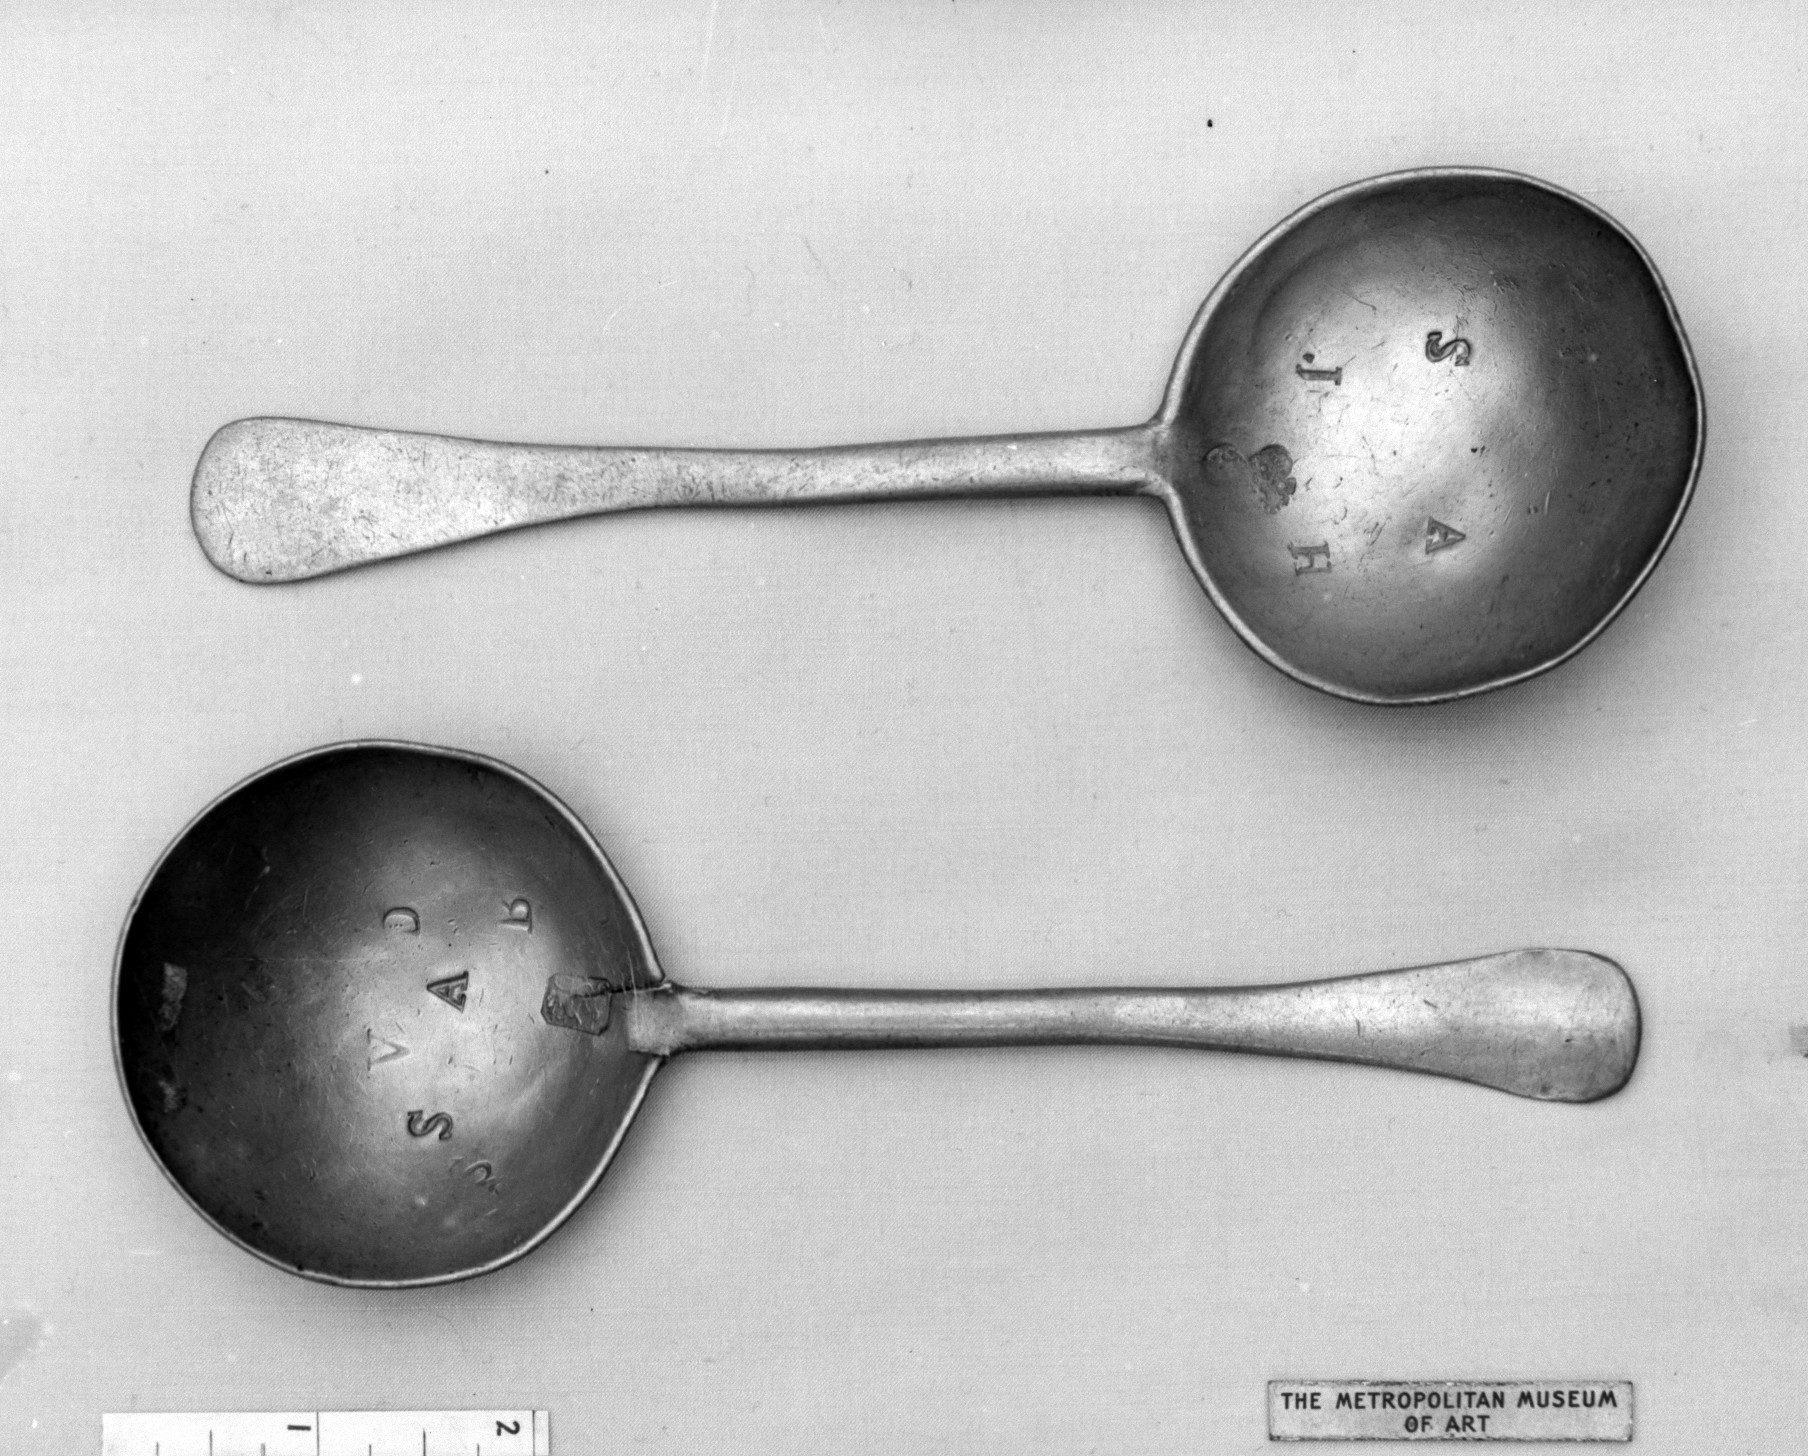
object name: spoon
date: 1701-1800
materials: pewter